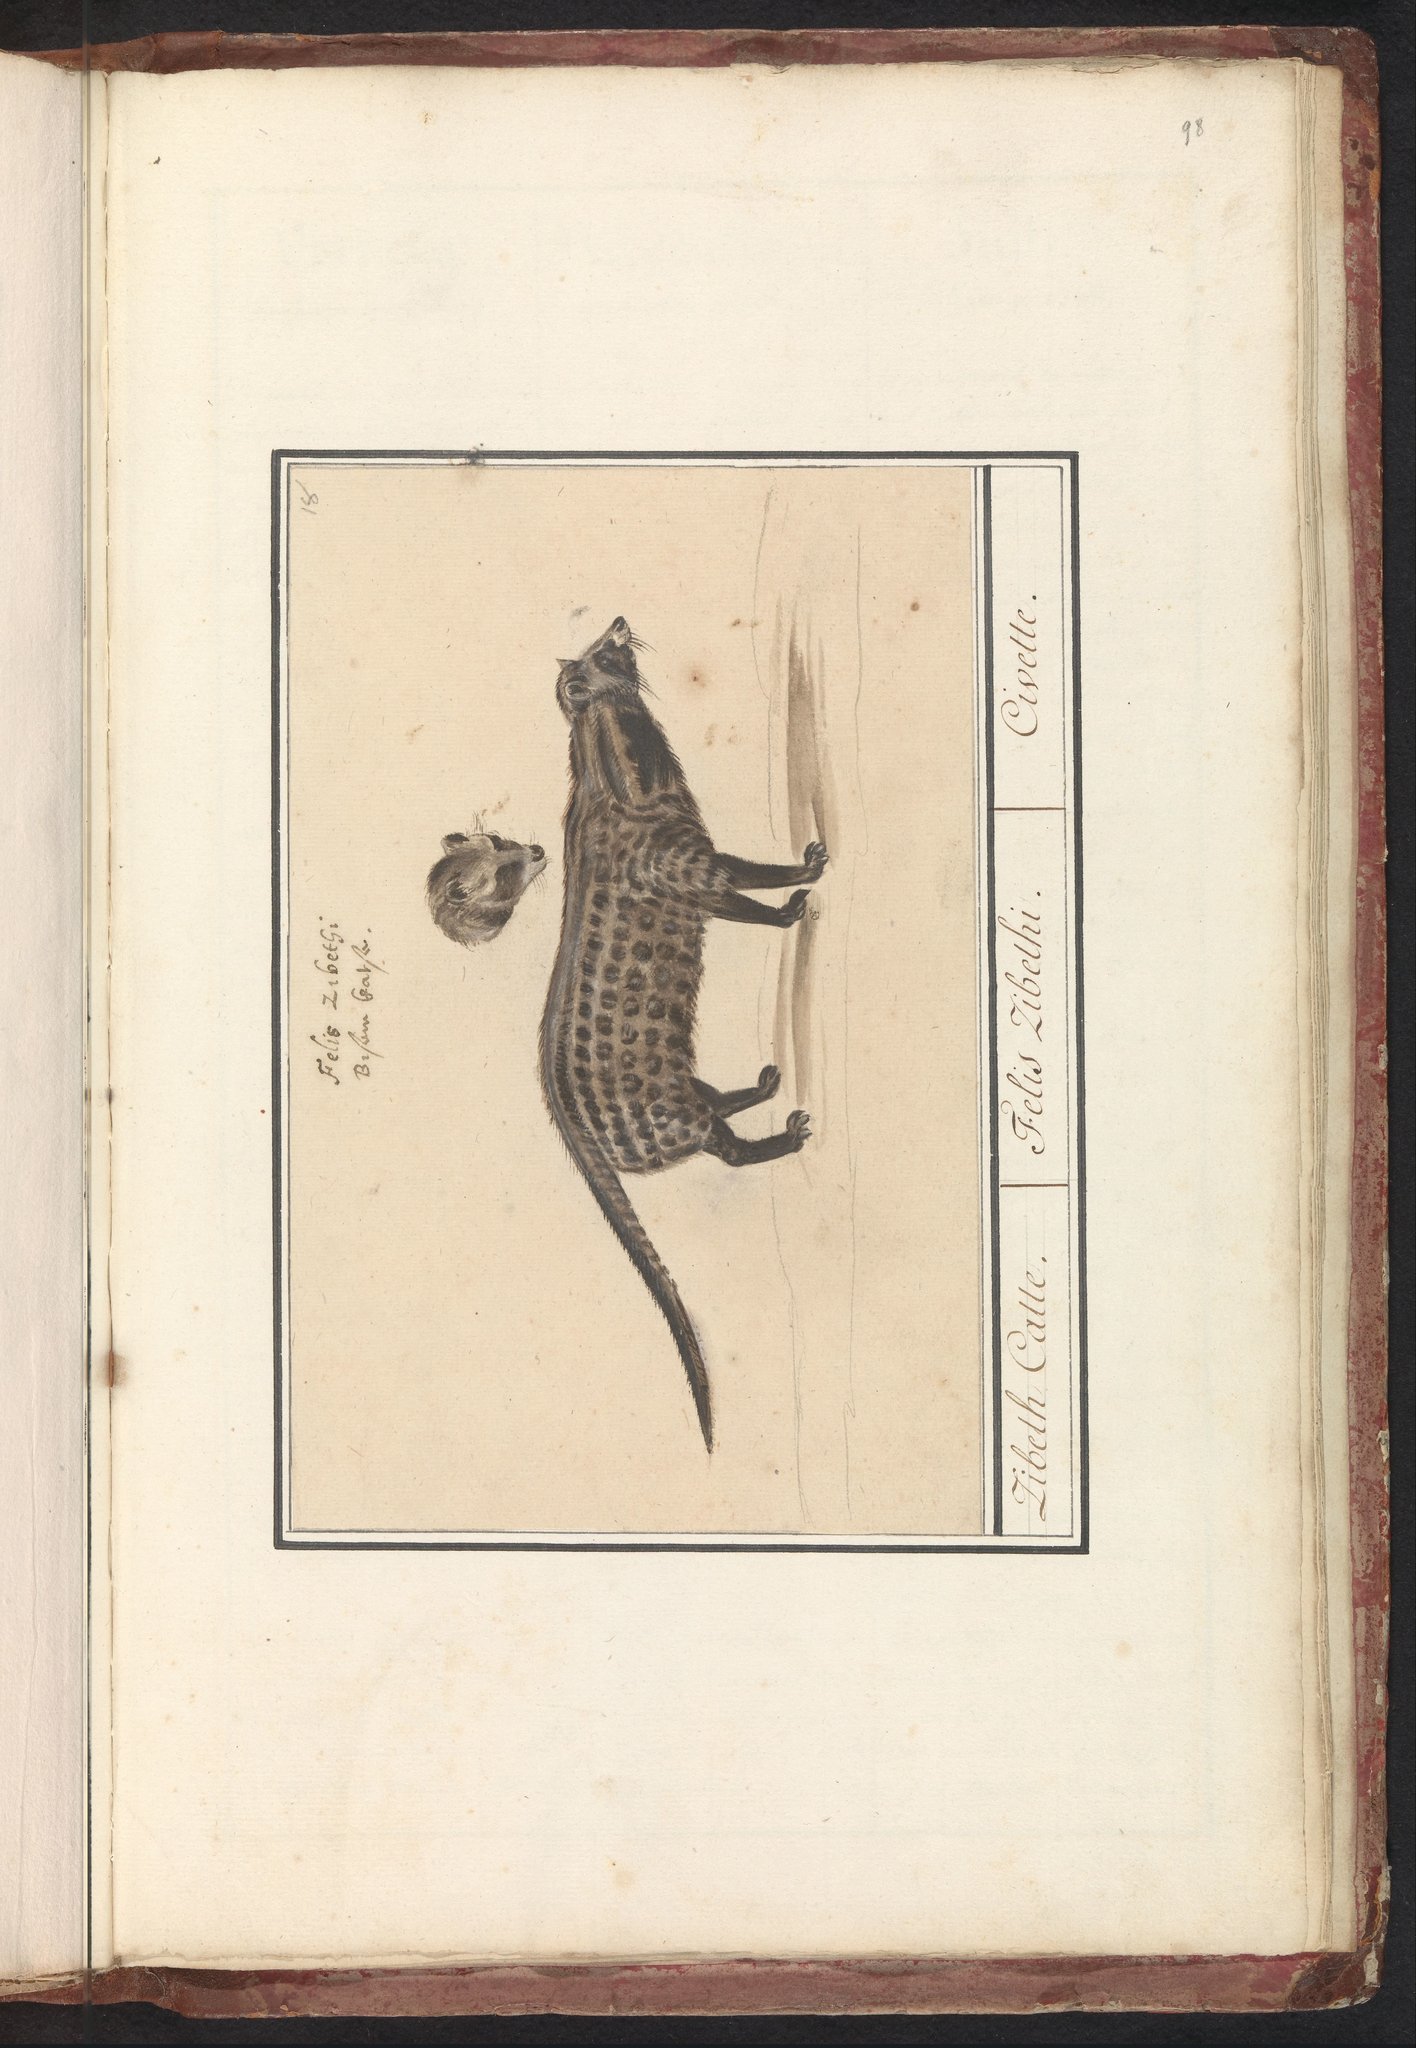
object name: drawing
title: Civetkat (Viverra)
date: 1596-1610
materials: paint, ink, paper, pencil, watercolor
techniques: brush, pen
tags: beasts of prey, predatory animals: civet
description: Civetkat. Met een detailstudie van de kop. Genummerd rechtsboven: 18. Bovenaan tweeregelig opschrift in het Latijn. Onderdeel van het eerste album met tekeningen van viervoeters. Eerste van twaalf albums met tekeningen van dieren, vogels en planten bekend rond 1600, gemaakt in opdracht van keizer Rudolf II. Met toelichting in Nederlands, Latijn en Frans.